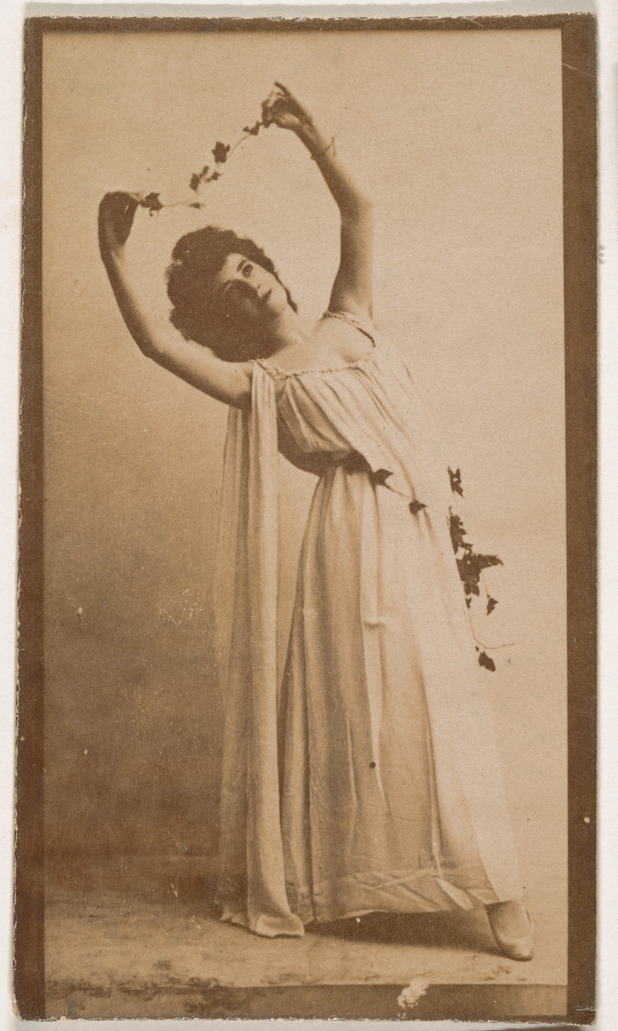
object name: photograph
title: Actress holding vine above head, from the Actresses series (N664) promoting Old Fashion Fine Cut Tobacco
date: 1888-1890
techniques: albumen silver print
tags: portraits,women,actresses